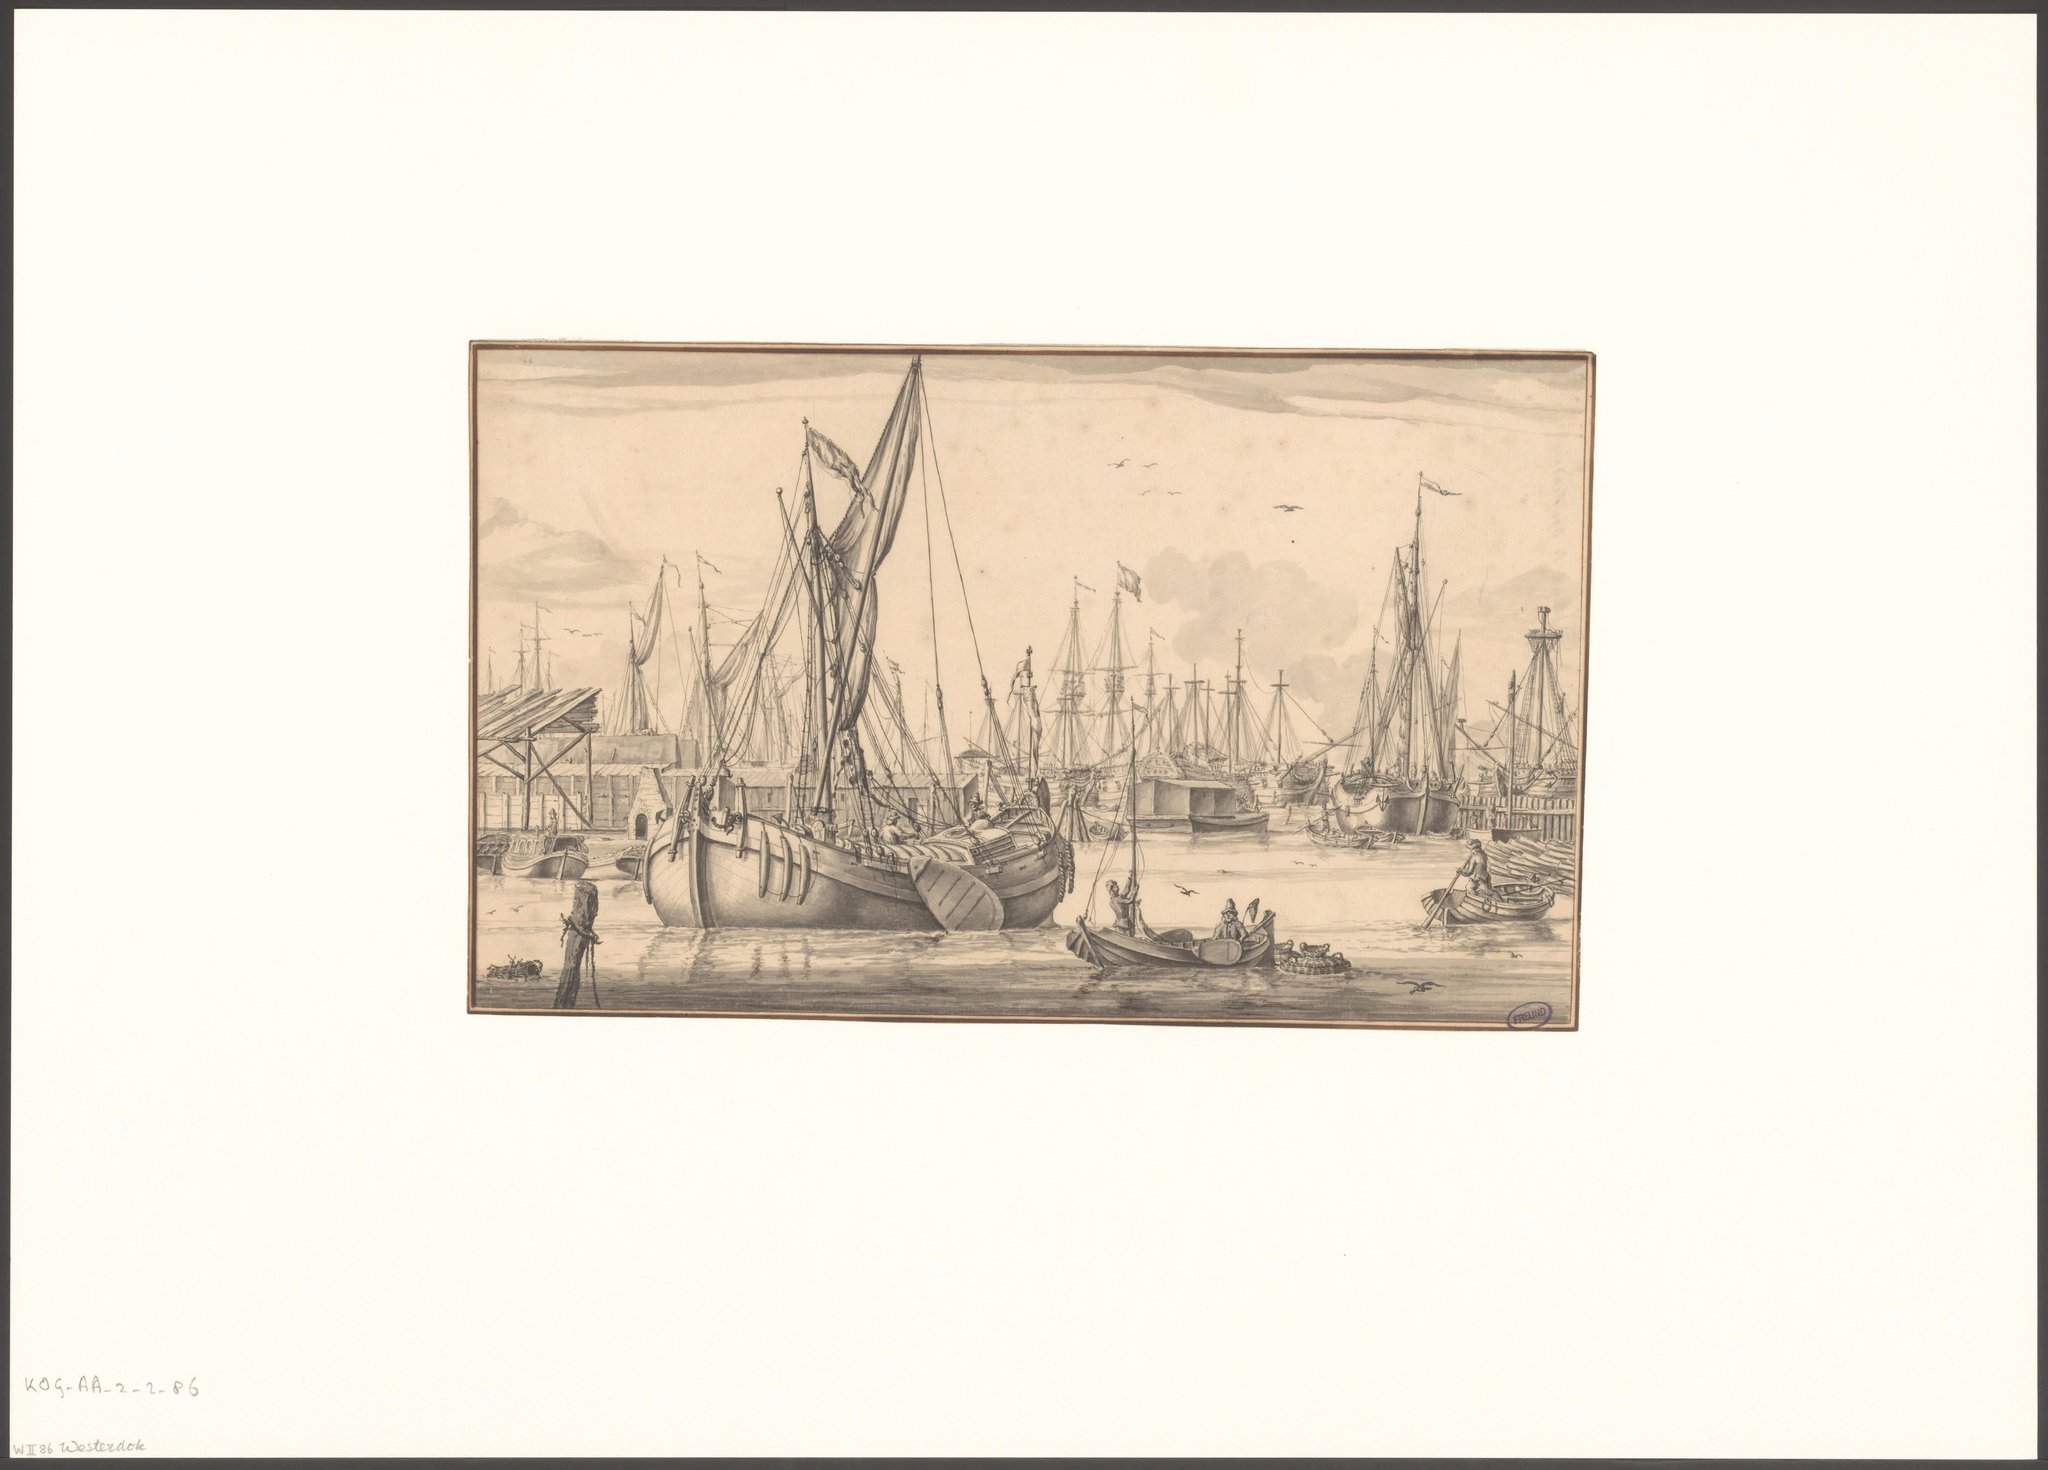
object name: drawing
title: Gezicht op de Westerdok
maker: pieter idserts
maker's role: draughtsman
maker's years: 1698-1781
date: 1708-1781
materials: paper, watercolor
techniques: brush, pen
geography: amsterdam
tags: sailing-ship, sailing-boat, city-view in general; 'veduta', river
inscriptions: collector's mark: Lugt 1713a, collector's mark: Lugt 800a, collector's mark: Lugt 954, inscription: ‘Antwerpse Beu[...]man en de Zandhoek te amsterdam’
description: Tekening binnen de Atlas Van Eck ingedeeld op wijknummer 2.